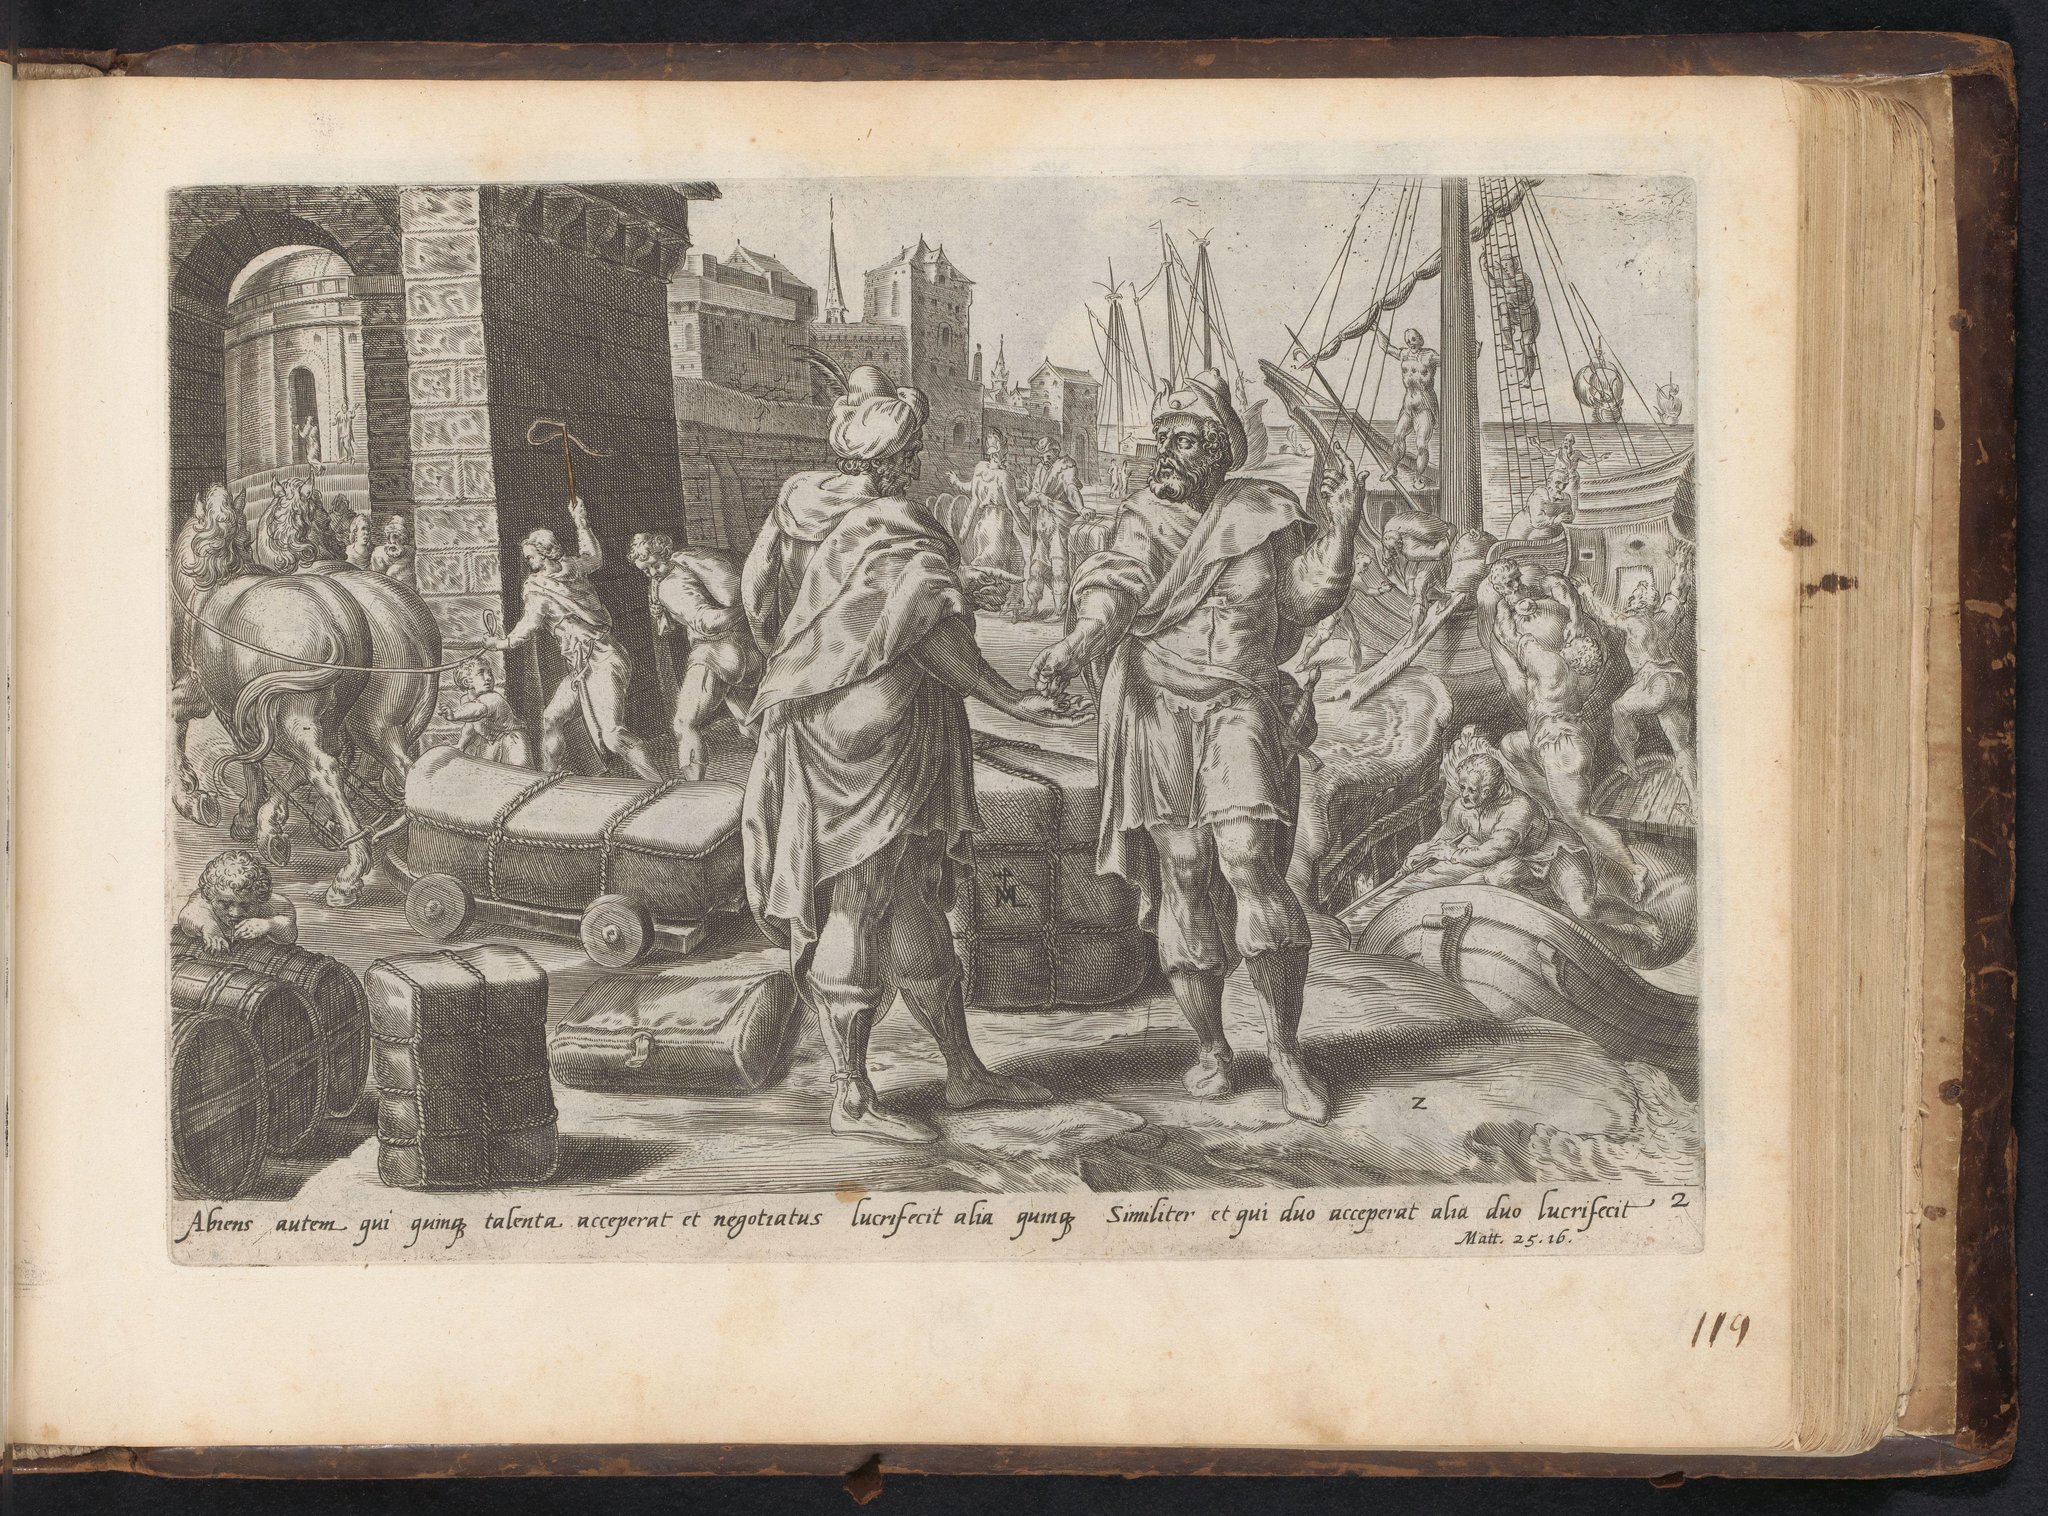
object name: print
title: Ghelijckenisse van d'wtghedeelde Talenten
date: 1565-1572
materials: paper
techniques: engraving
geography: alkmaar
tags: two servants trade with the money; one servant buries it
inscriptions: number: ‘119’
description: De dienaar, die vijf talenten van zijn heer heeft gekregen, drijft handel in de haven van een stad. Te midden van pakken en tonnen op de kade geeft hij geld aan een handelaar. Onder de voorstelling een verwijzing in het Latijn naar de Bijbeltekst in Mat. 25:16. Deze prent maakt deel uit van een album.